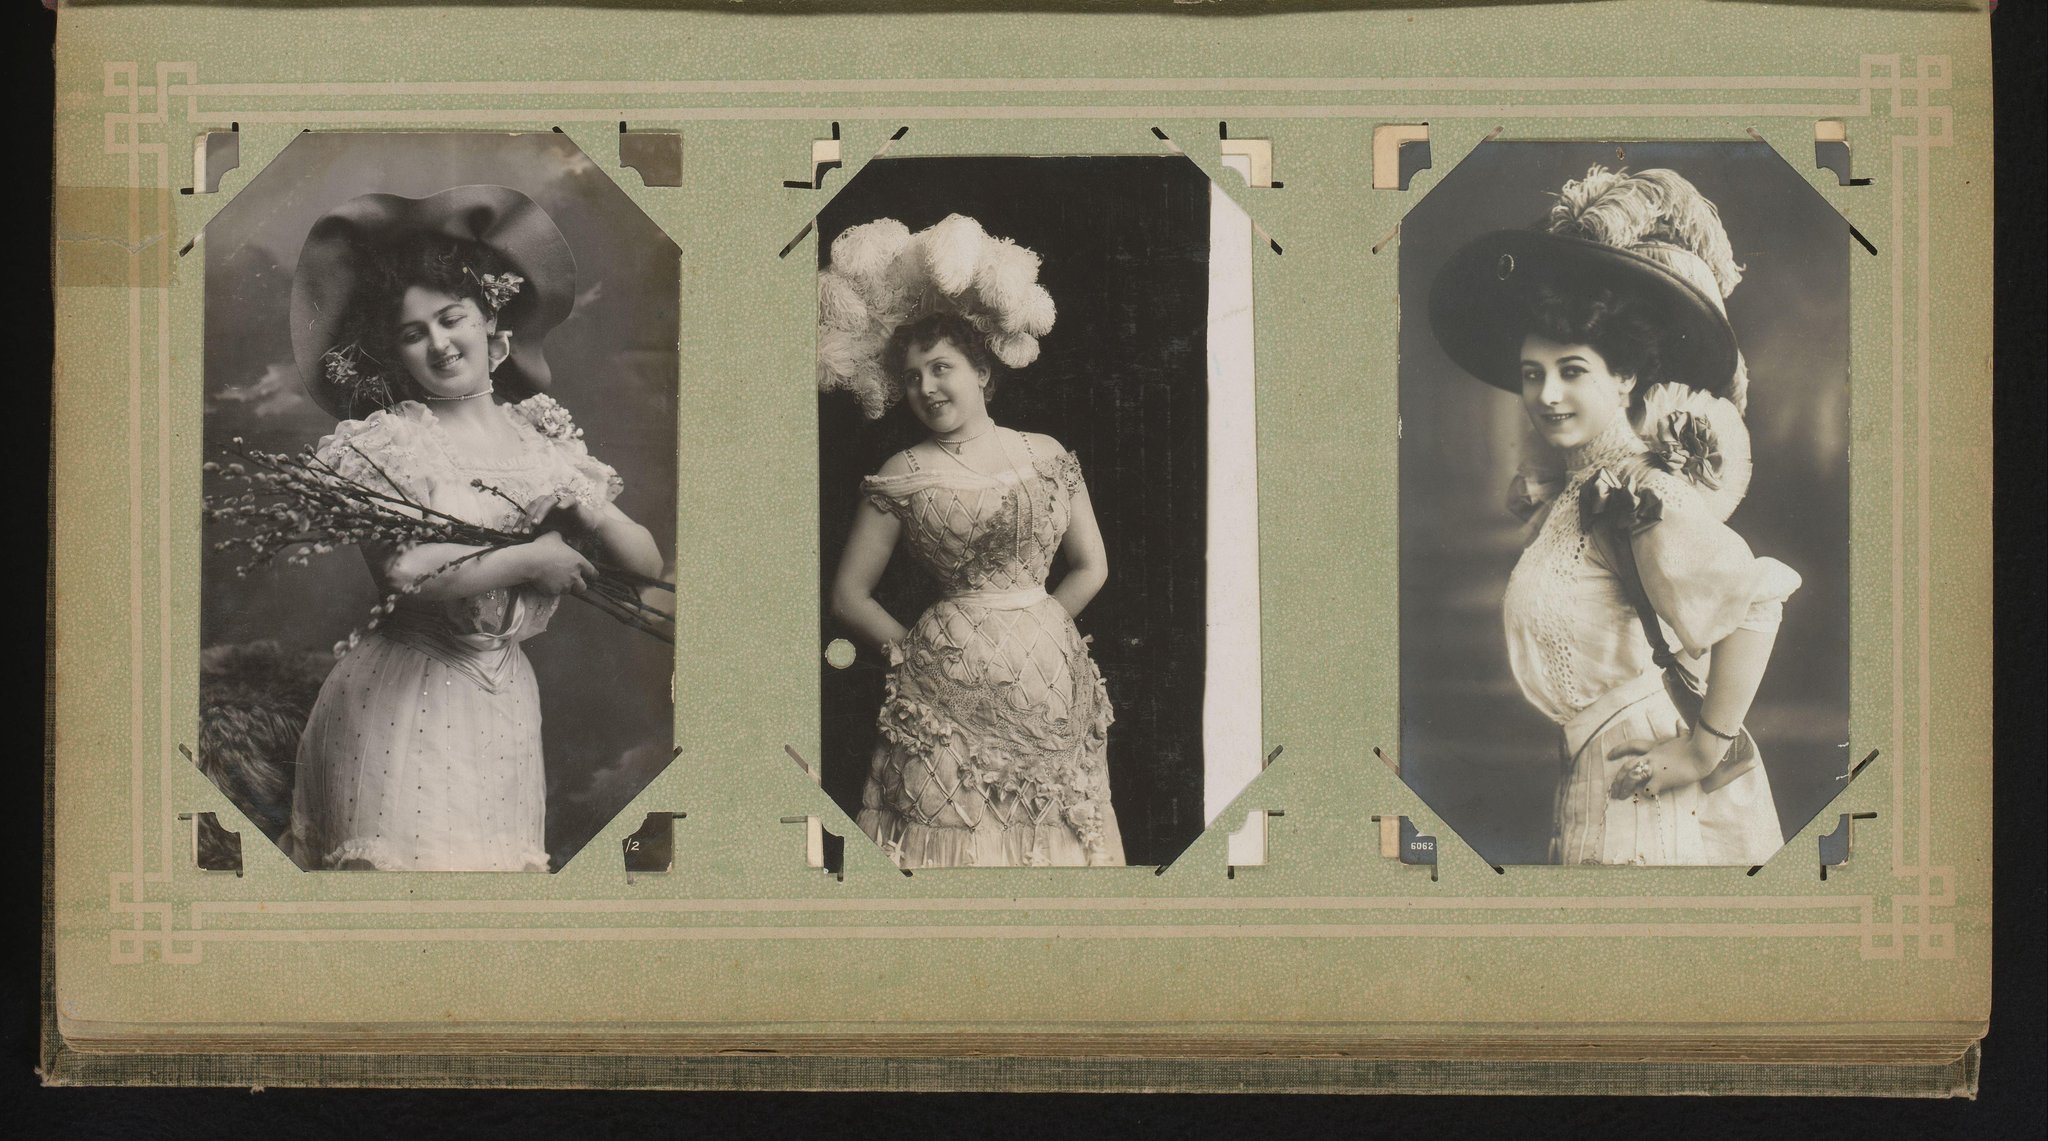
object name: album leaf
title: Drie portretten van vrouwen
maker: Anonymous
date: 1900-1930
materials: cardboard, photographic support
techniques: gelatin silver print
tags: historical persons - bb - woman, head-gear: hat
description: Deze foto's maken deel uit van een album.